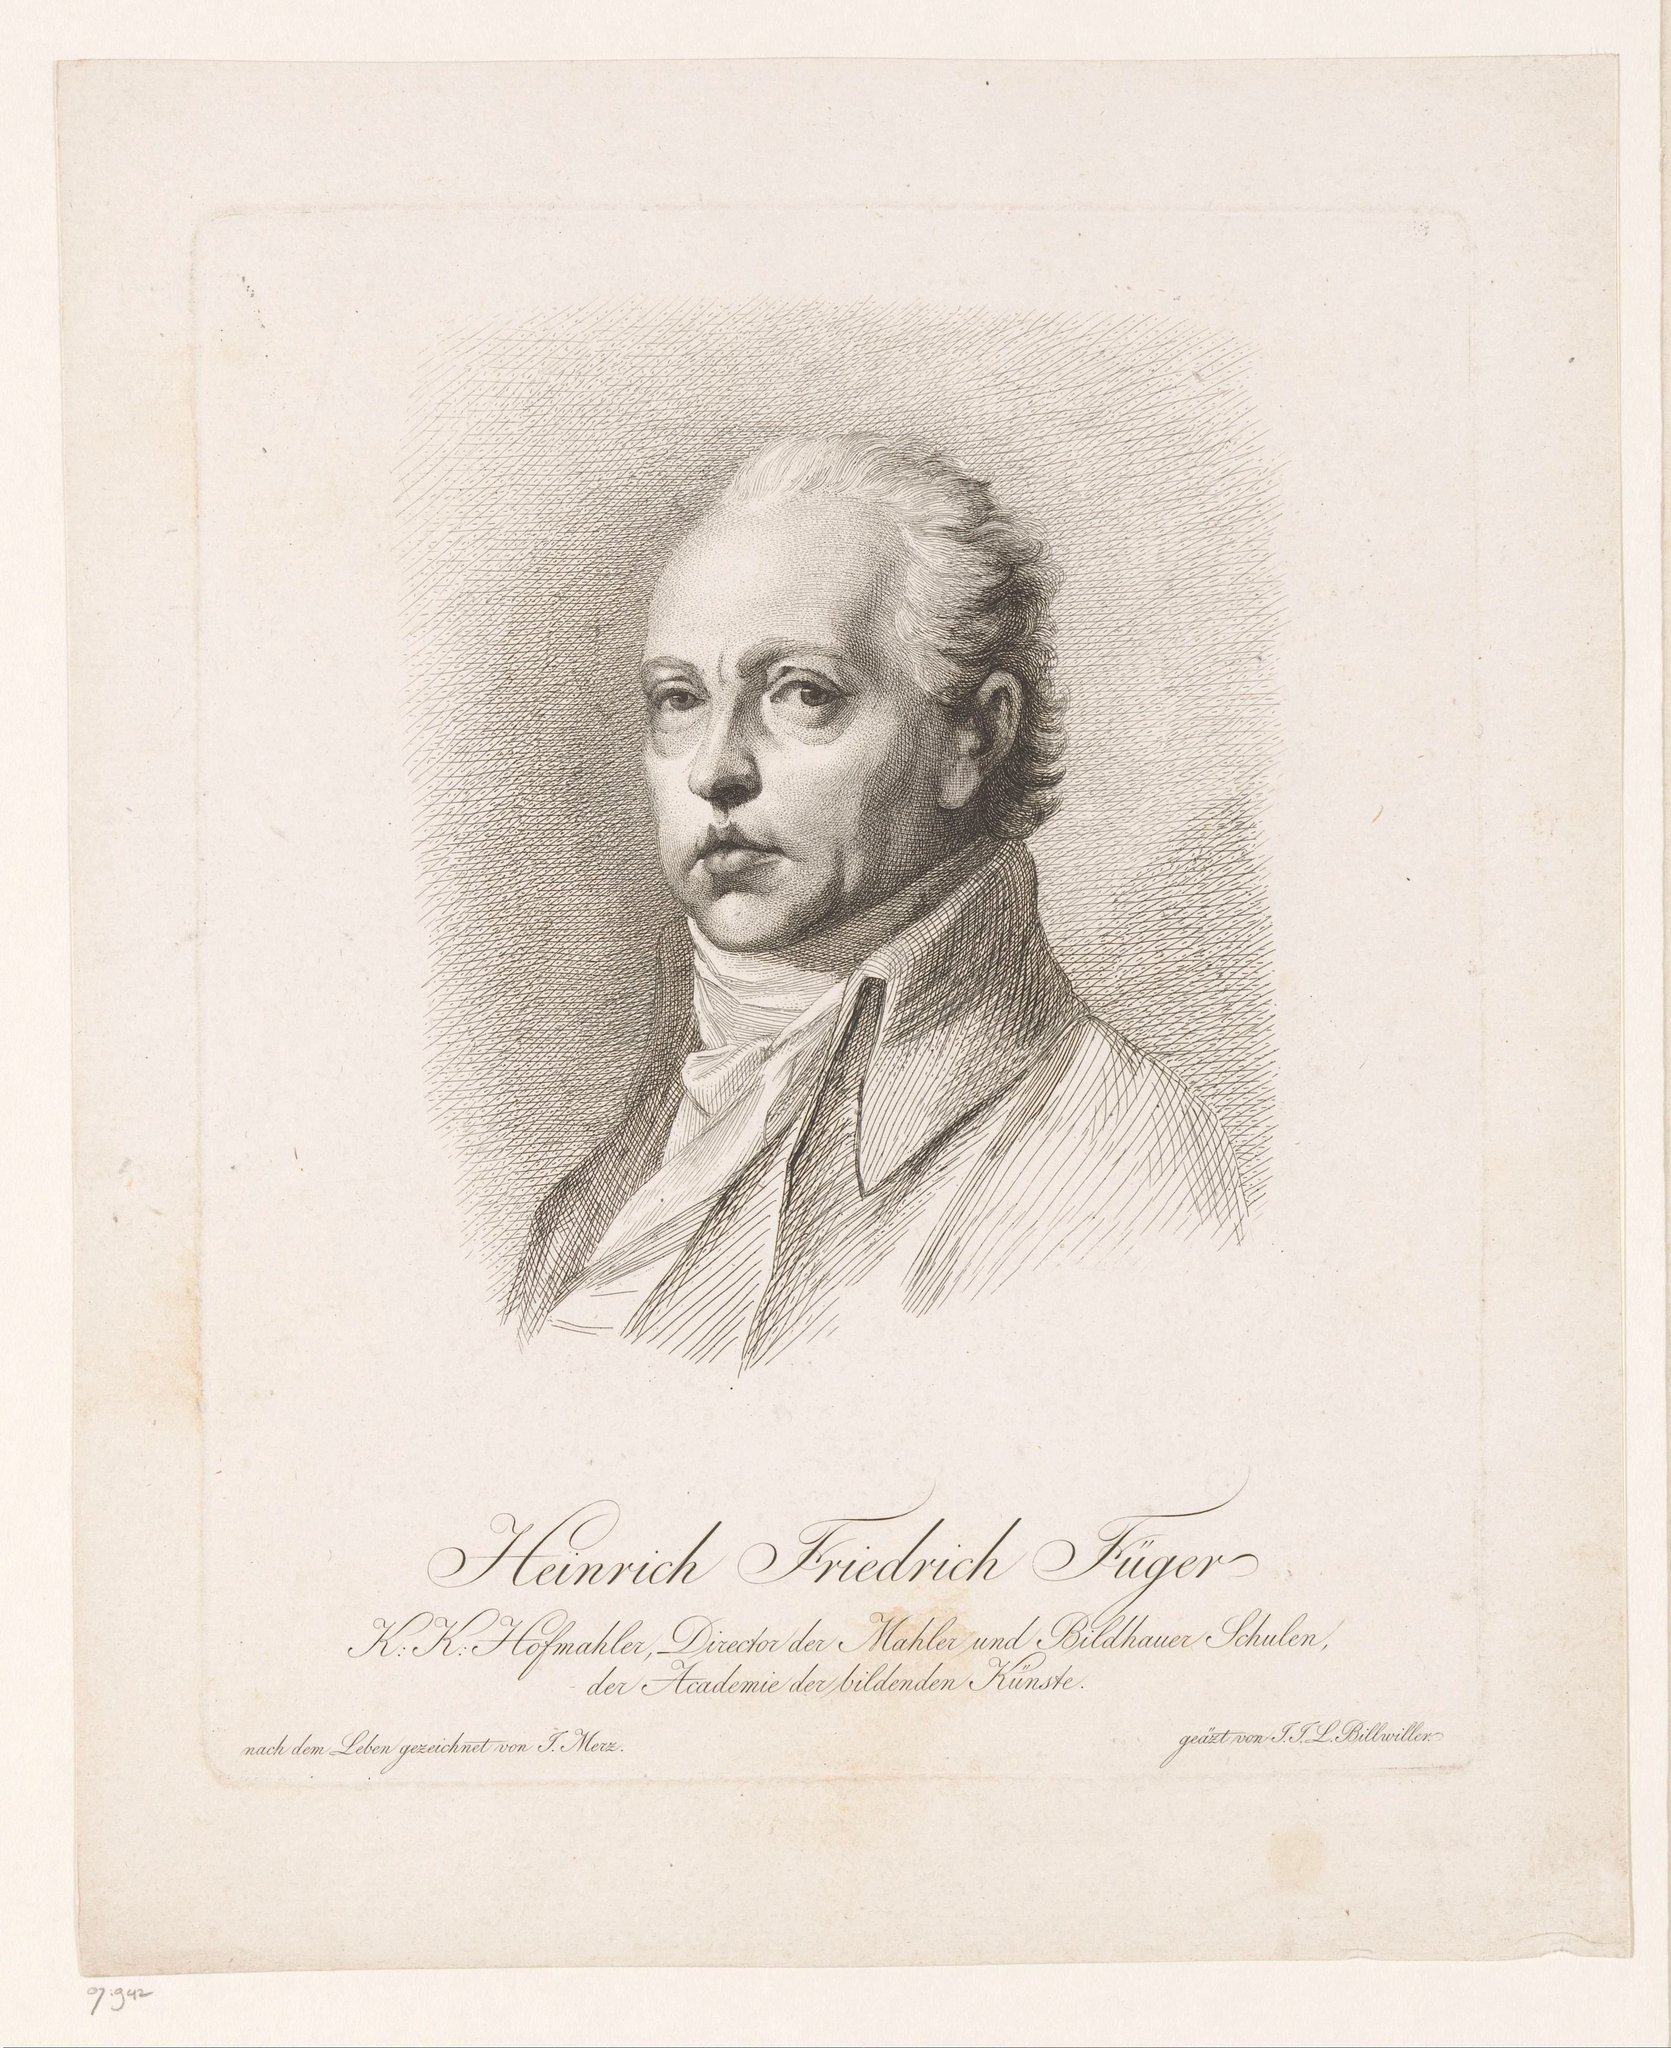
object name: print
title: Portret van Friedrich Heinrich Füger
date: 1805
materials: paper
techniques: etching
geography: vienna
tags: vienna, painter, artist, friedrich heinrich füger, portrait, self-portrait of artist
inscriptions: collector's mark: Lugt 2228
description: De prent maakt onderdeel uit van een serie van zes portretten van docenten werkzaam aan de Akademie der bildenden Künste te Wenen.